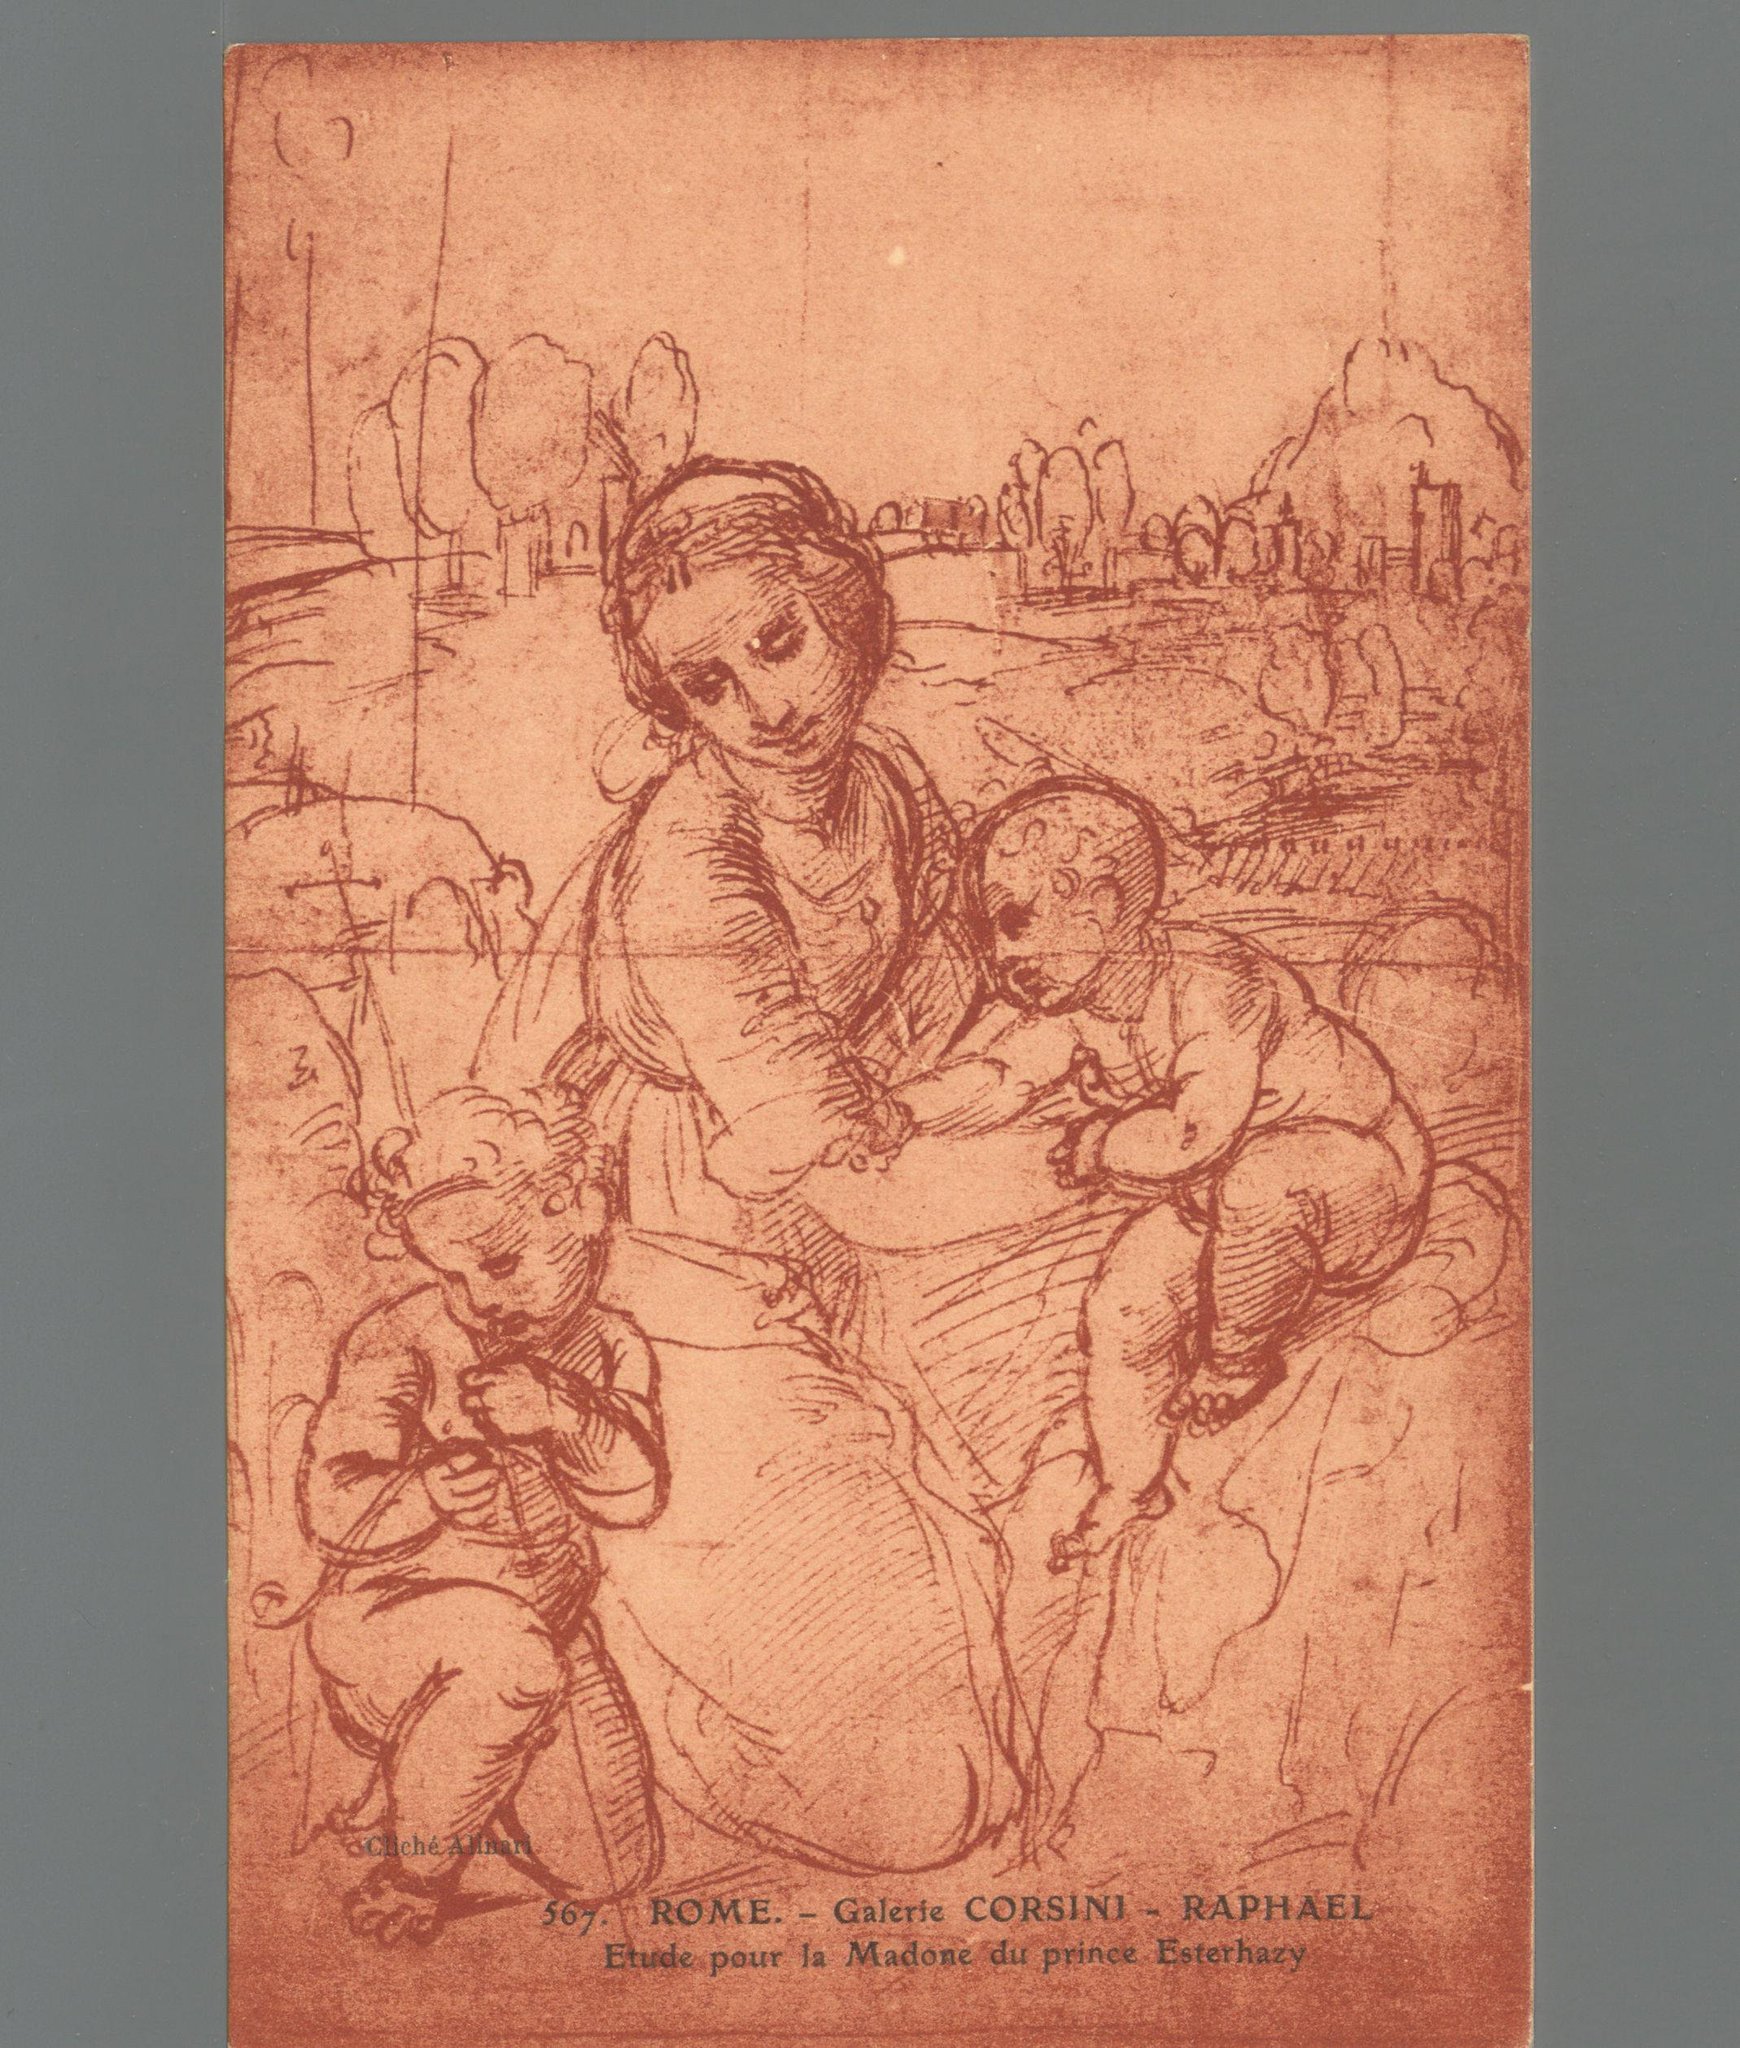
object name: ansichtkaart, prentbriefkaart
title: Rome.- Galerie Corsini - Raphael. Etude pour la Madone du prince Esterhazy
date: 1906-1930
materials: cardboard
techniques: photograph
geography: paris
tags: picture, painting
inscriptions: collector's mark: ‘AFE v S’